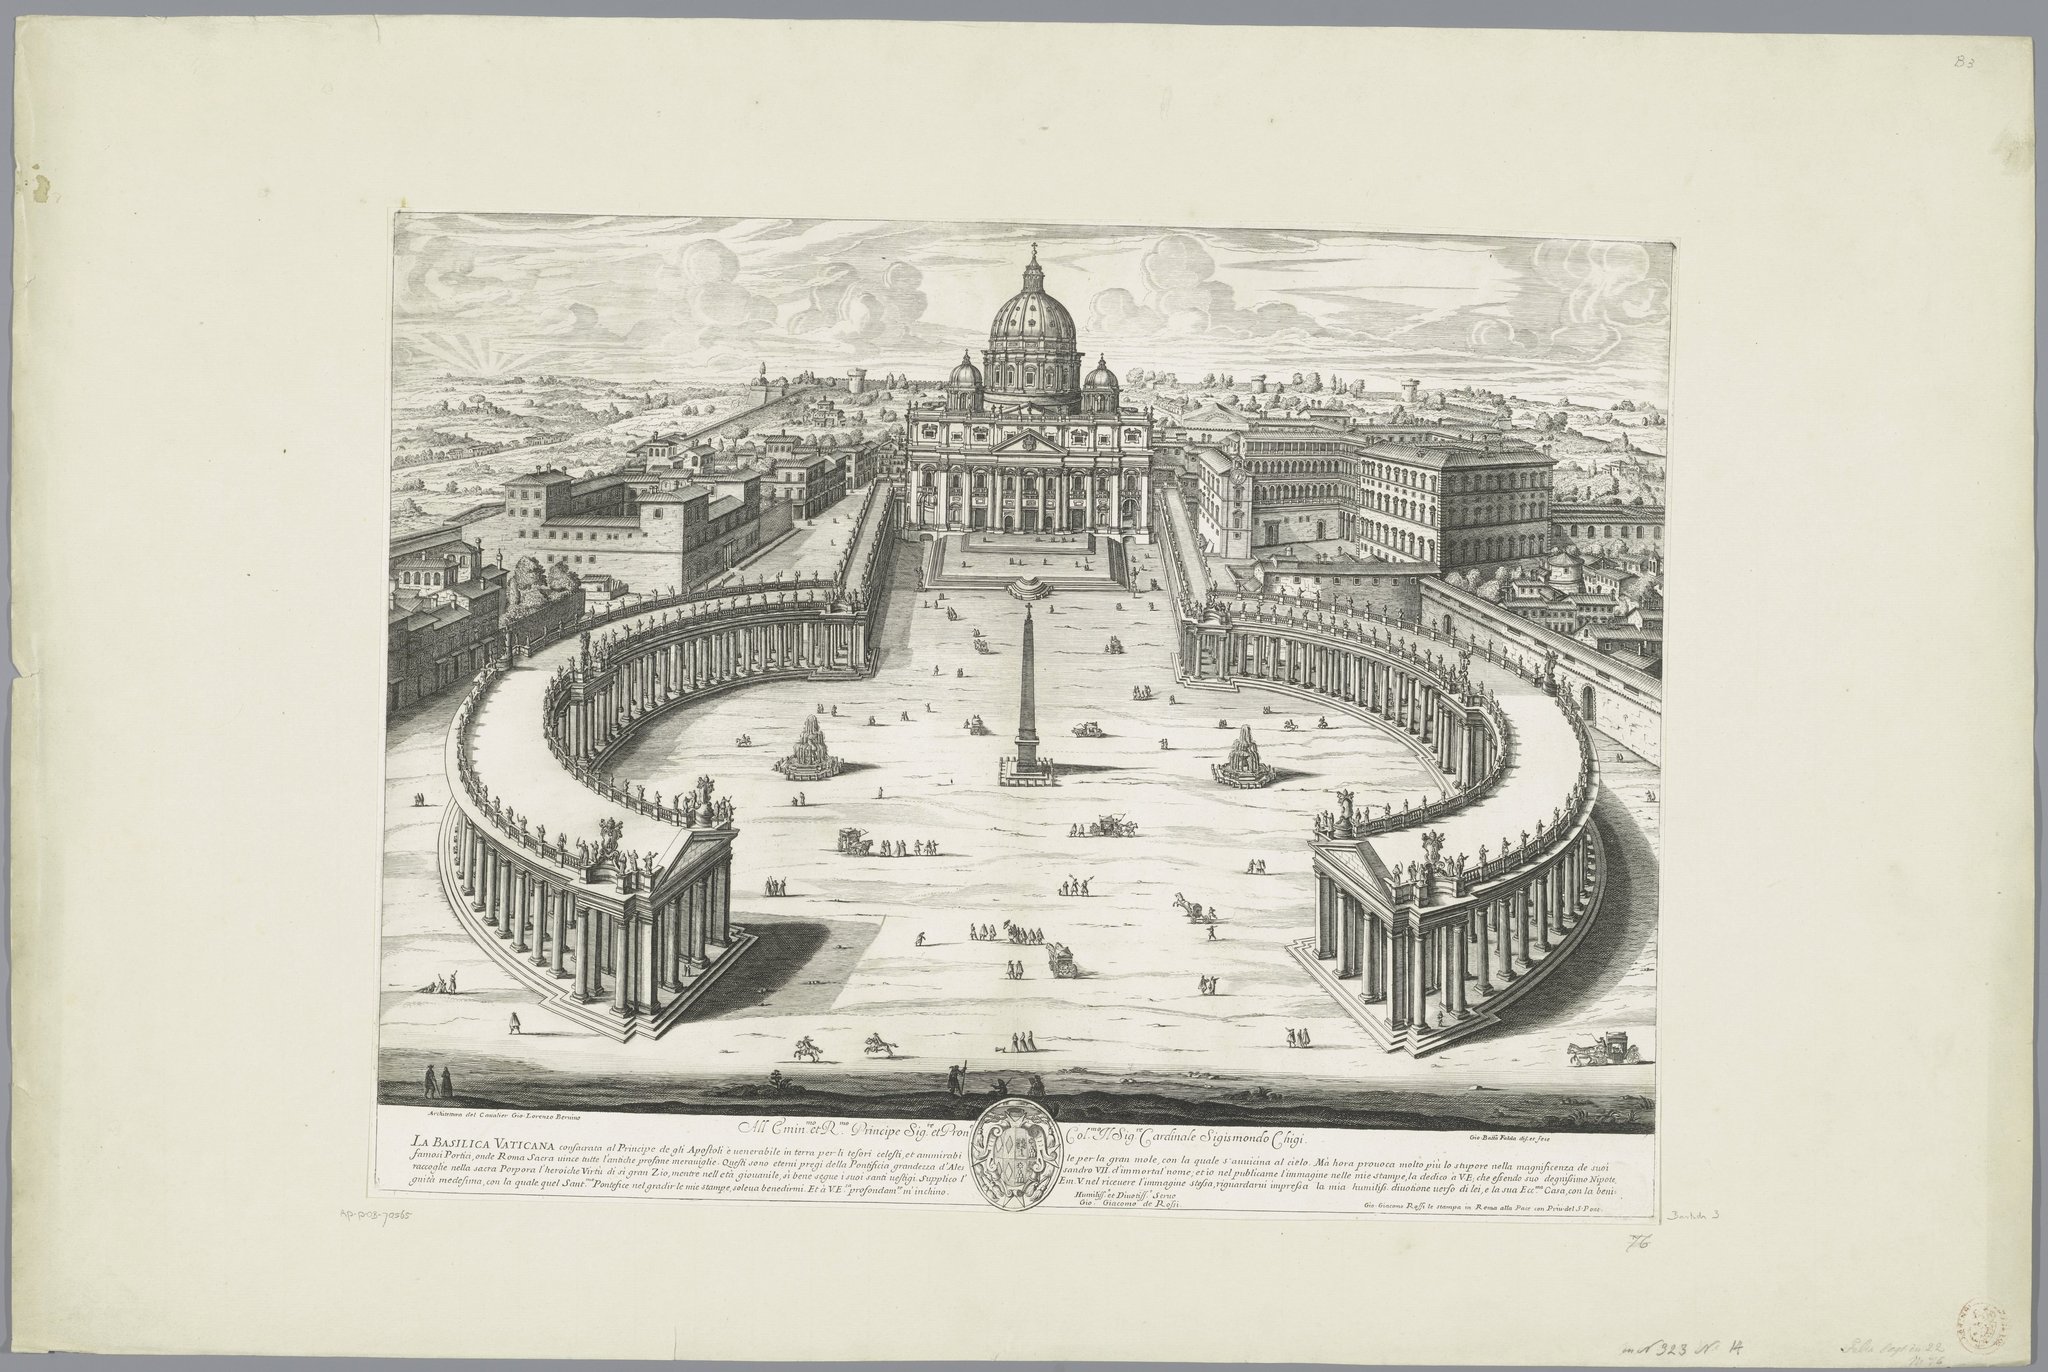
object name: print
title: Gezicht op het Sint-Pietersplein te Vaticaanstad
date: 1578-1678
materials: paper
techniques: engraving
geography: vatican city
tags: church (exterior)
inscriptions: collector's mark: Lugt 240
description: Gezicht op het het Sint-Pietersplein te Vaticaanstad met de Sint-Pietersbasiliek en het Apostolisch Paleis. Opdracht, tekst en wapenschild van kardinaal Sigismondo Chigi in ondermarge.